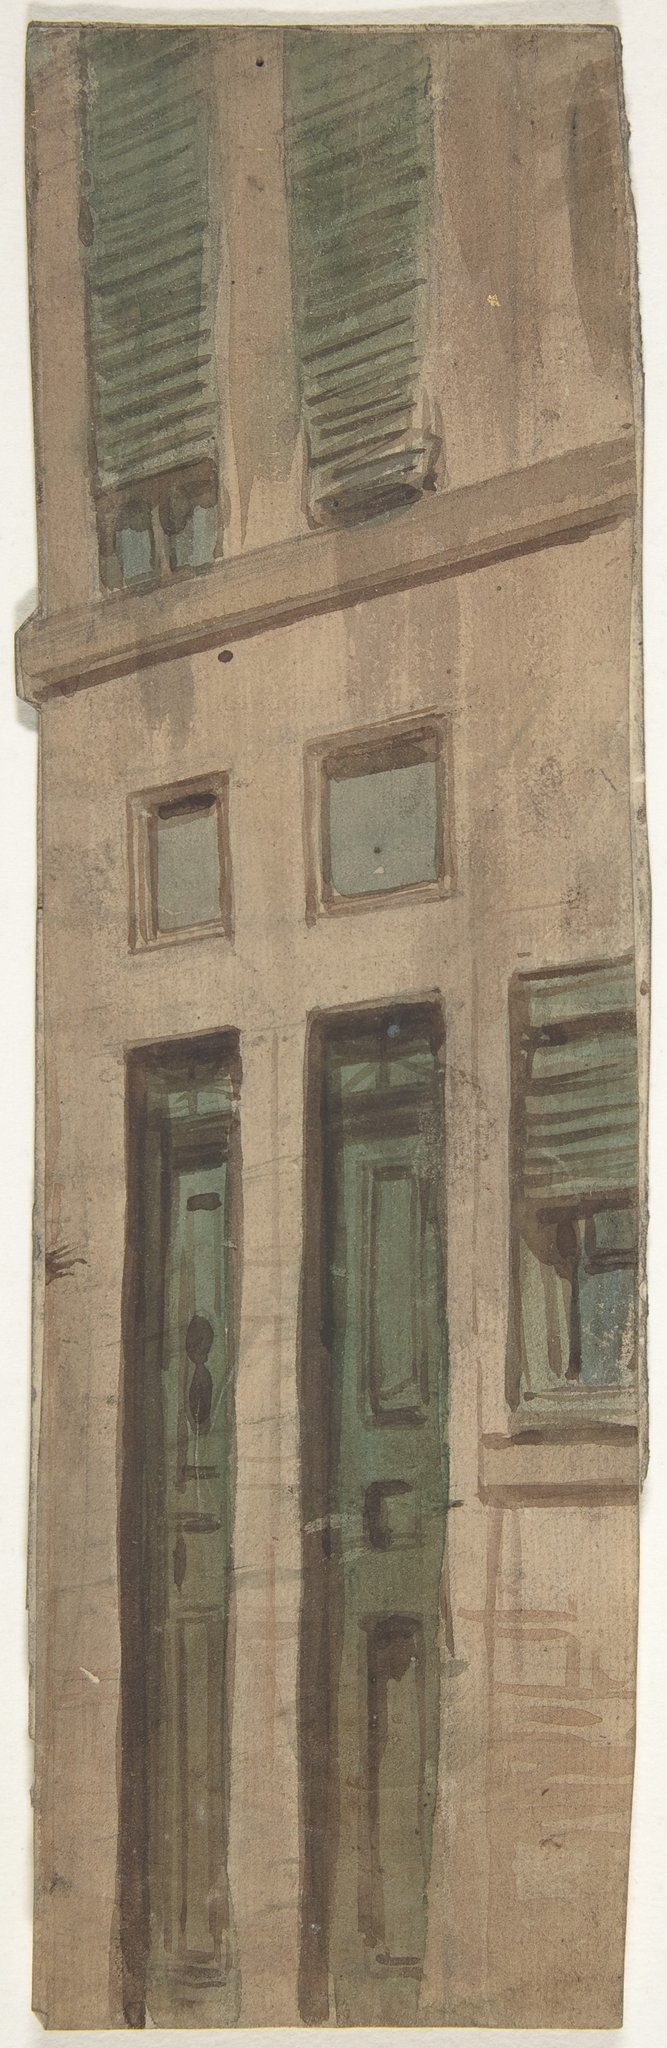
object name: drawing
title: Design for a Stage Set at the Opéra, Paris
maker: eugène cicéri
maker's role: artist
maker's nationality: french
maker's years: 1813-1890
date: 1830-1890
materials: graphite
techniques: brush, wash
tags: stage design